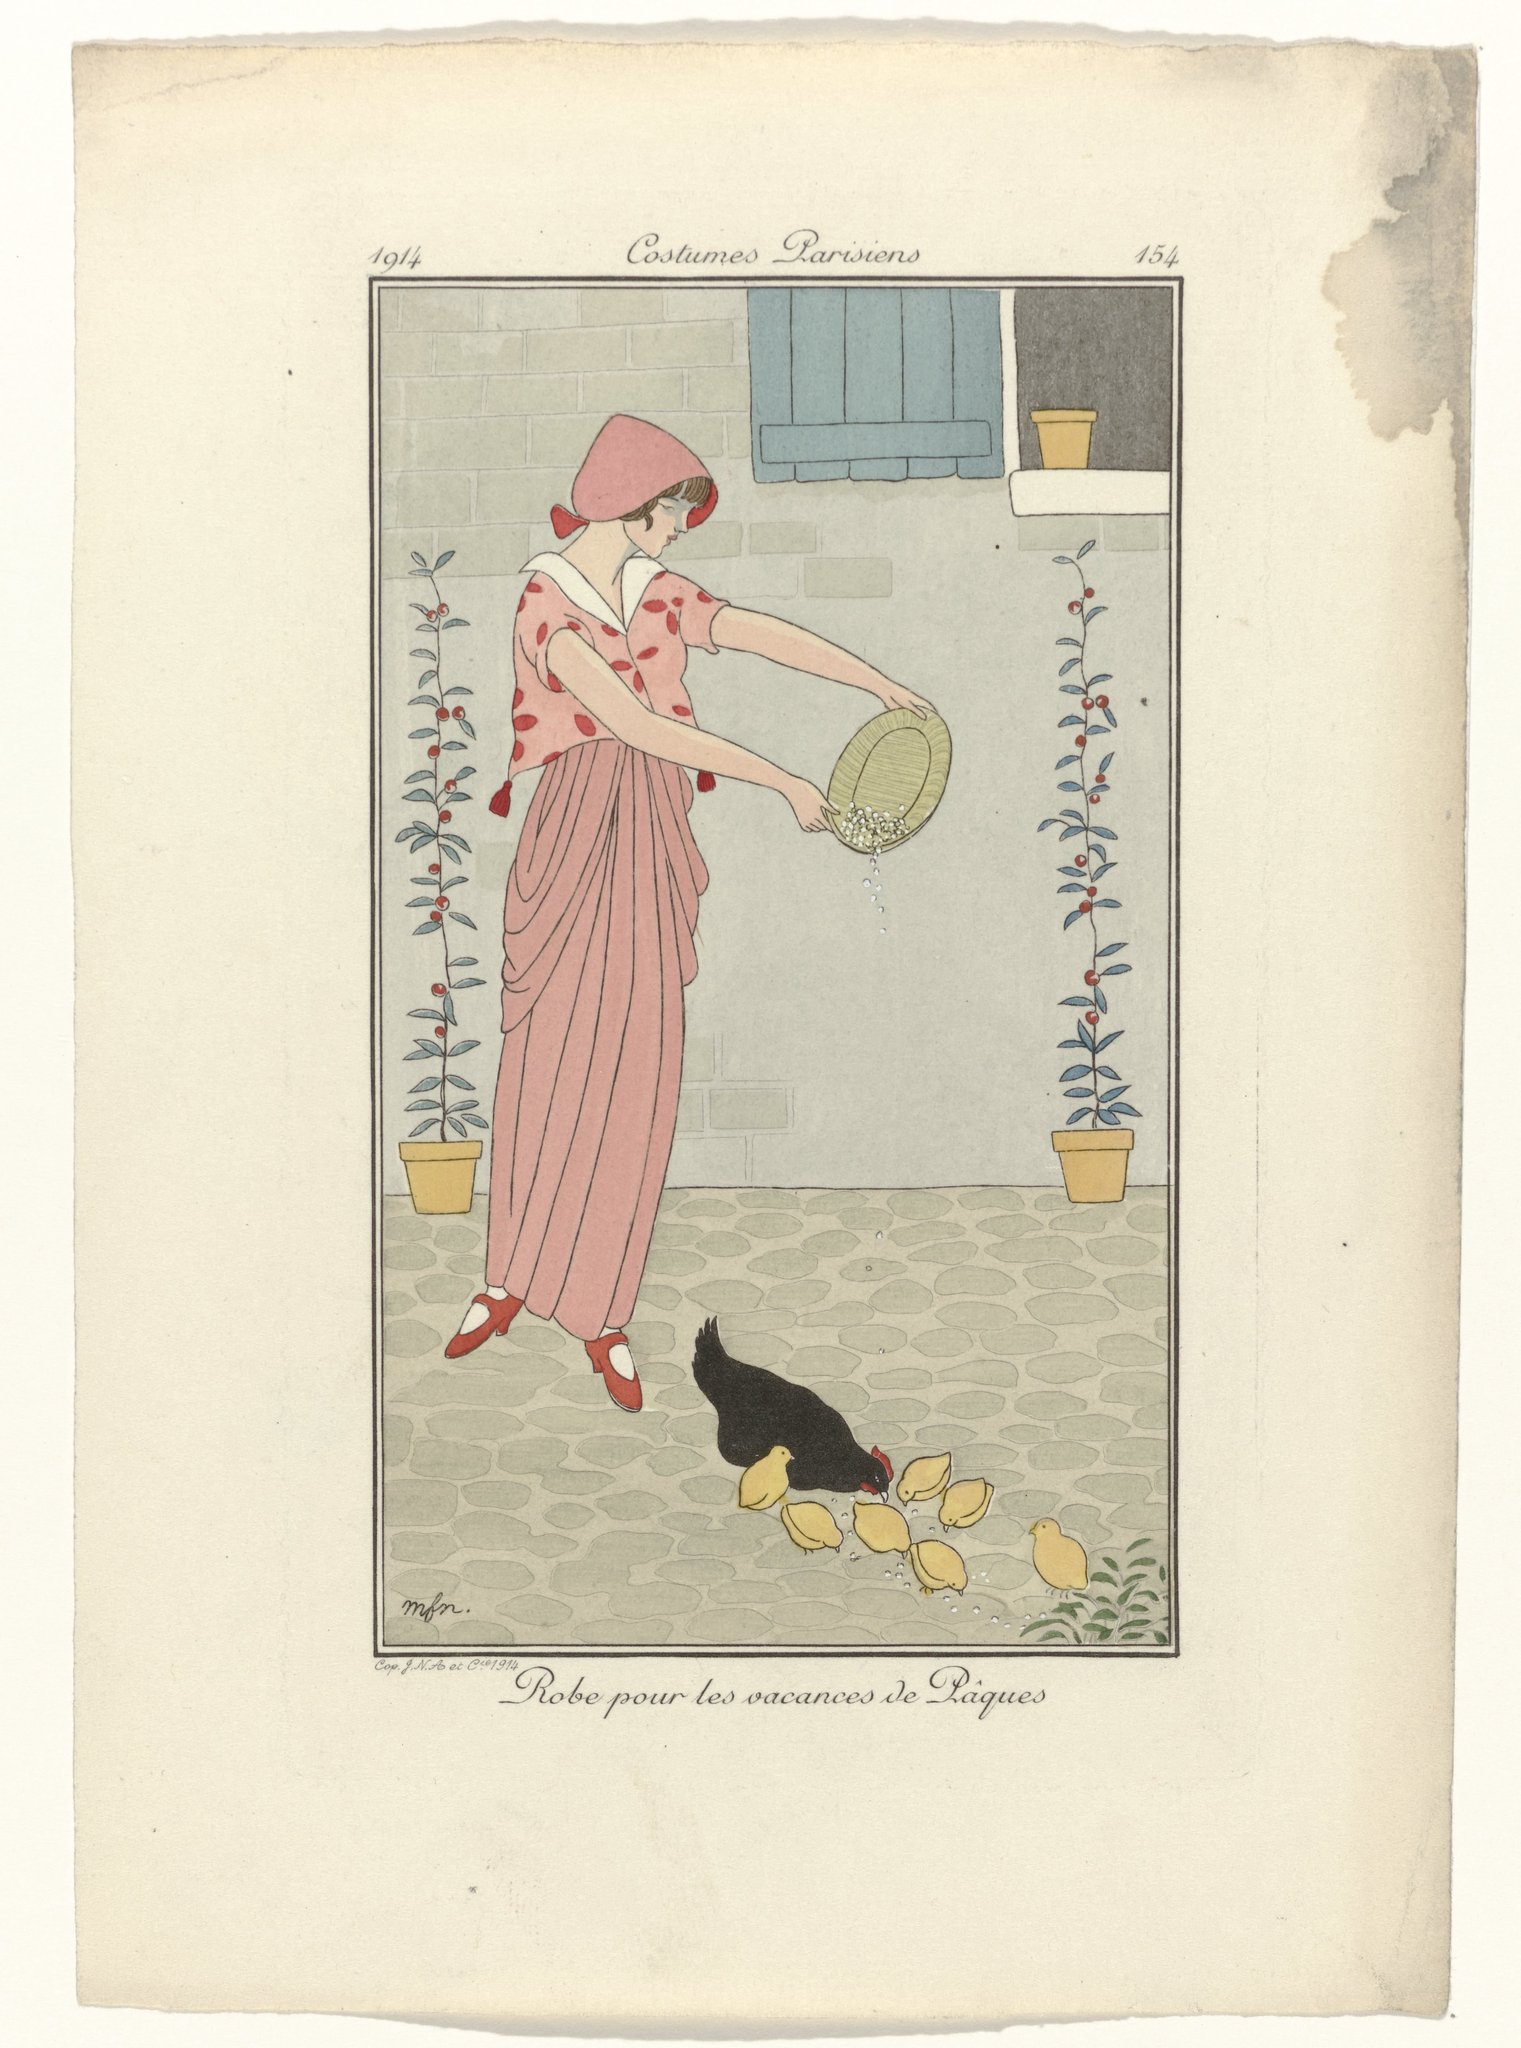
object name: fashion print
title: Journal des Dames et des Modes, Costumes Parisiens, 1914, No. 154 : Robe pour les vacances (...)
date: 1914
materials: paper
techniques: engraving, hand coloring, pochoir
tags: fowl (cock, hen, chicken, etc.) (+ feeding animal), head-gear (+ women's clothes), fashion plates, dress, gown (+ women's clothes)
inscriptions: caption: ‘Robe pour les vacances de Pâques’, inscription: ‘Cop. J. N. A. et Cie 1914’, title: ‘Costumes Parisiens’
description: Vrouw in een jurk met korte mouwen en lange geplooide rok. Zij is bezig een kip met kuikens te voeren. Volgens het onderschrift is dit een jurk voor tijdens de paasvakantie. Prent uit het modetijdschrift Journal des Dames et des Modes (1912-1914).